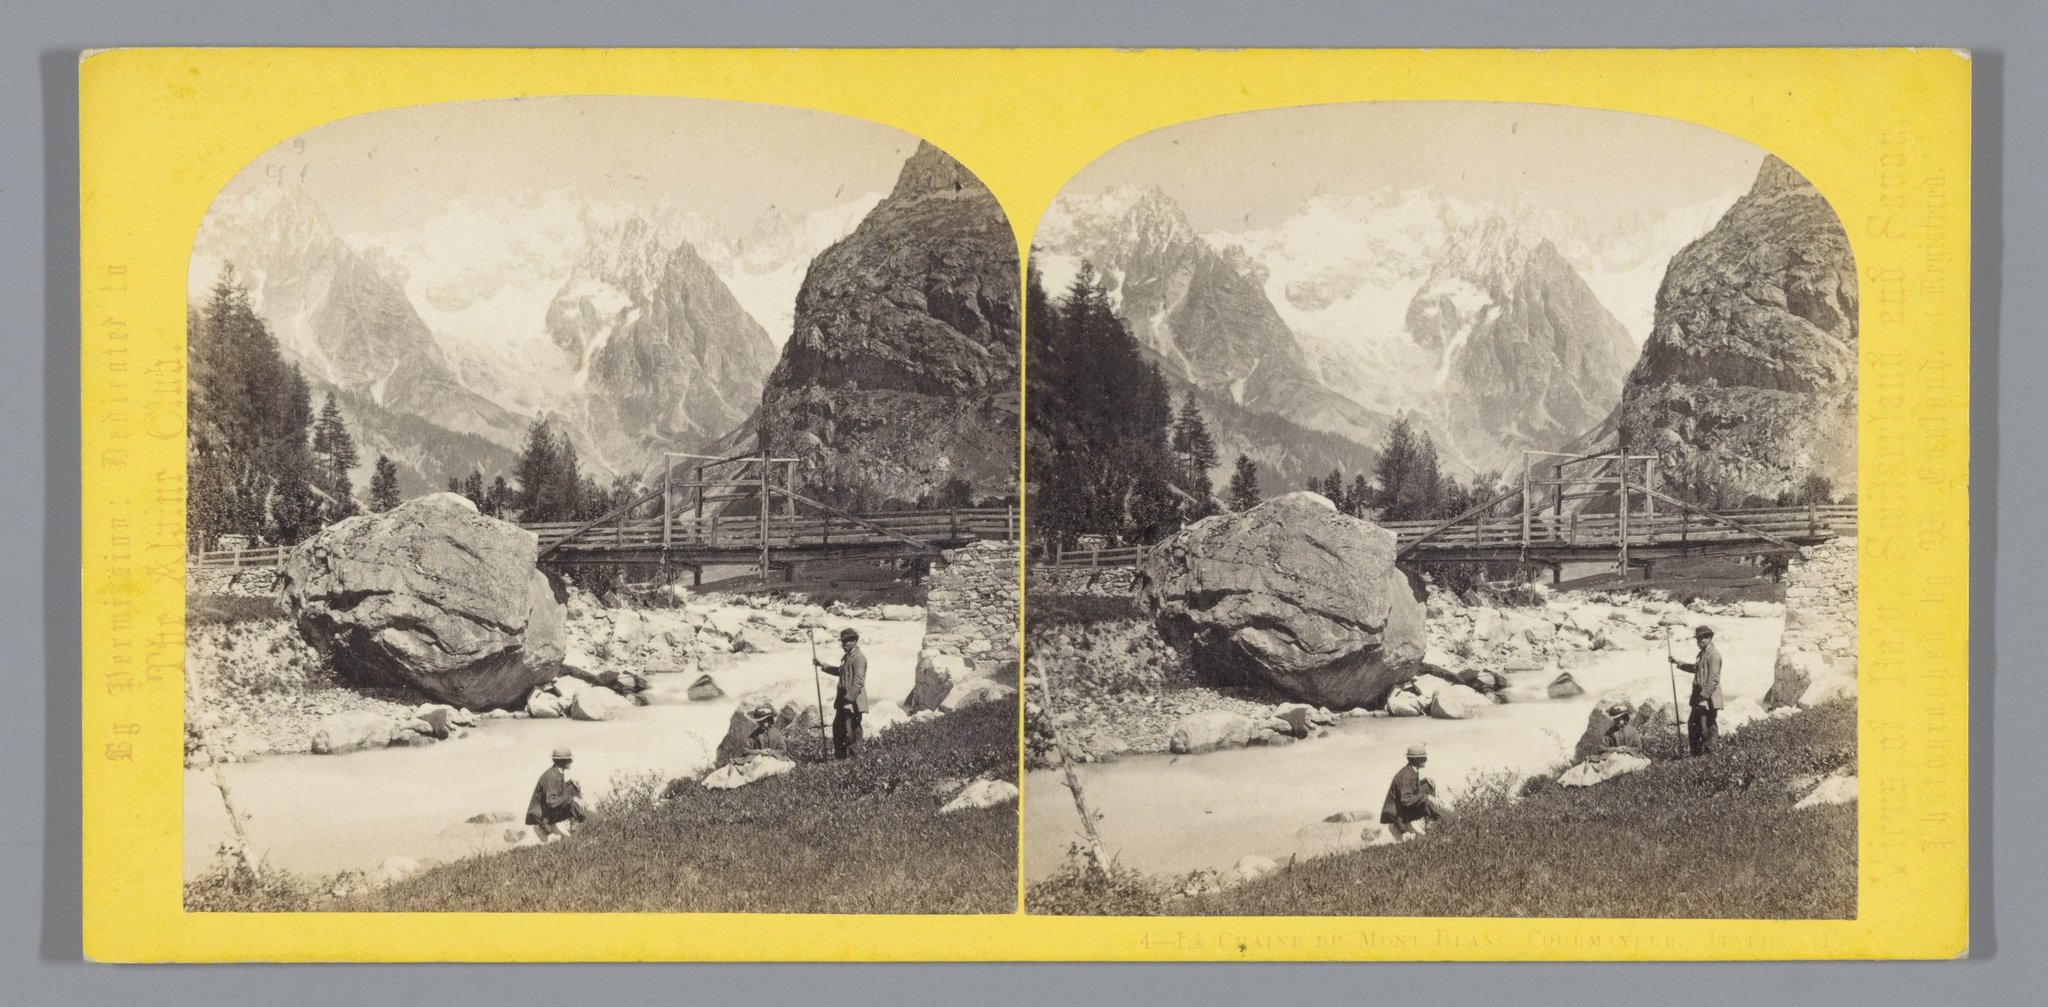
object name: stereograph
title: La Chaine du Mont Blanc, Courmayeur. Italie (1)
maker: william england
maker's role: fotograaf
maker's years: 1816-1896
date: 1850-1880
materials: cardboard, photographic support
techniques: albumen print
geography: courmayeur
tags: mountain-range, snow peaks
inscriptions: number: ‘4’, inscription: ‘N4. Chaine du Mont Blanc Courmayeur Italie’, inscription: ‘By Permission: Dedicated to The Alpine Club’